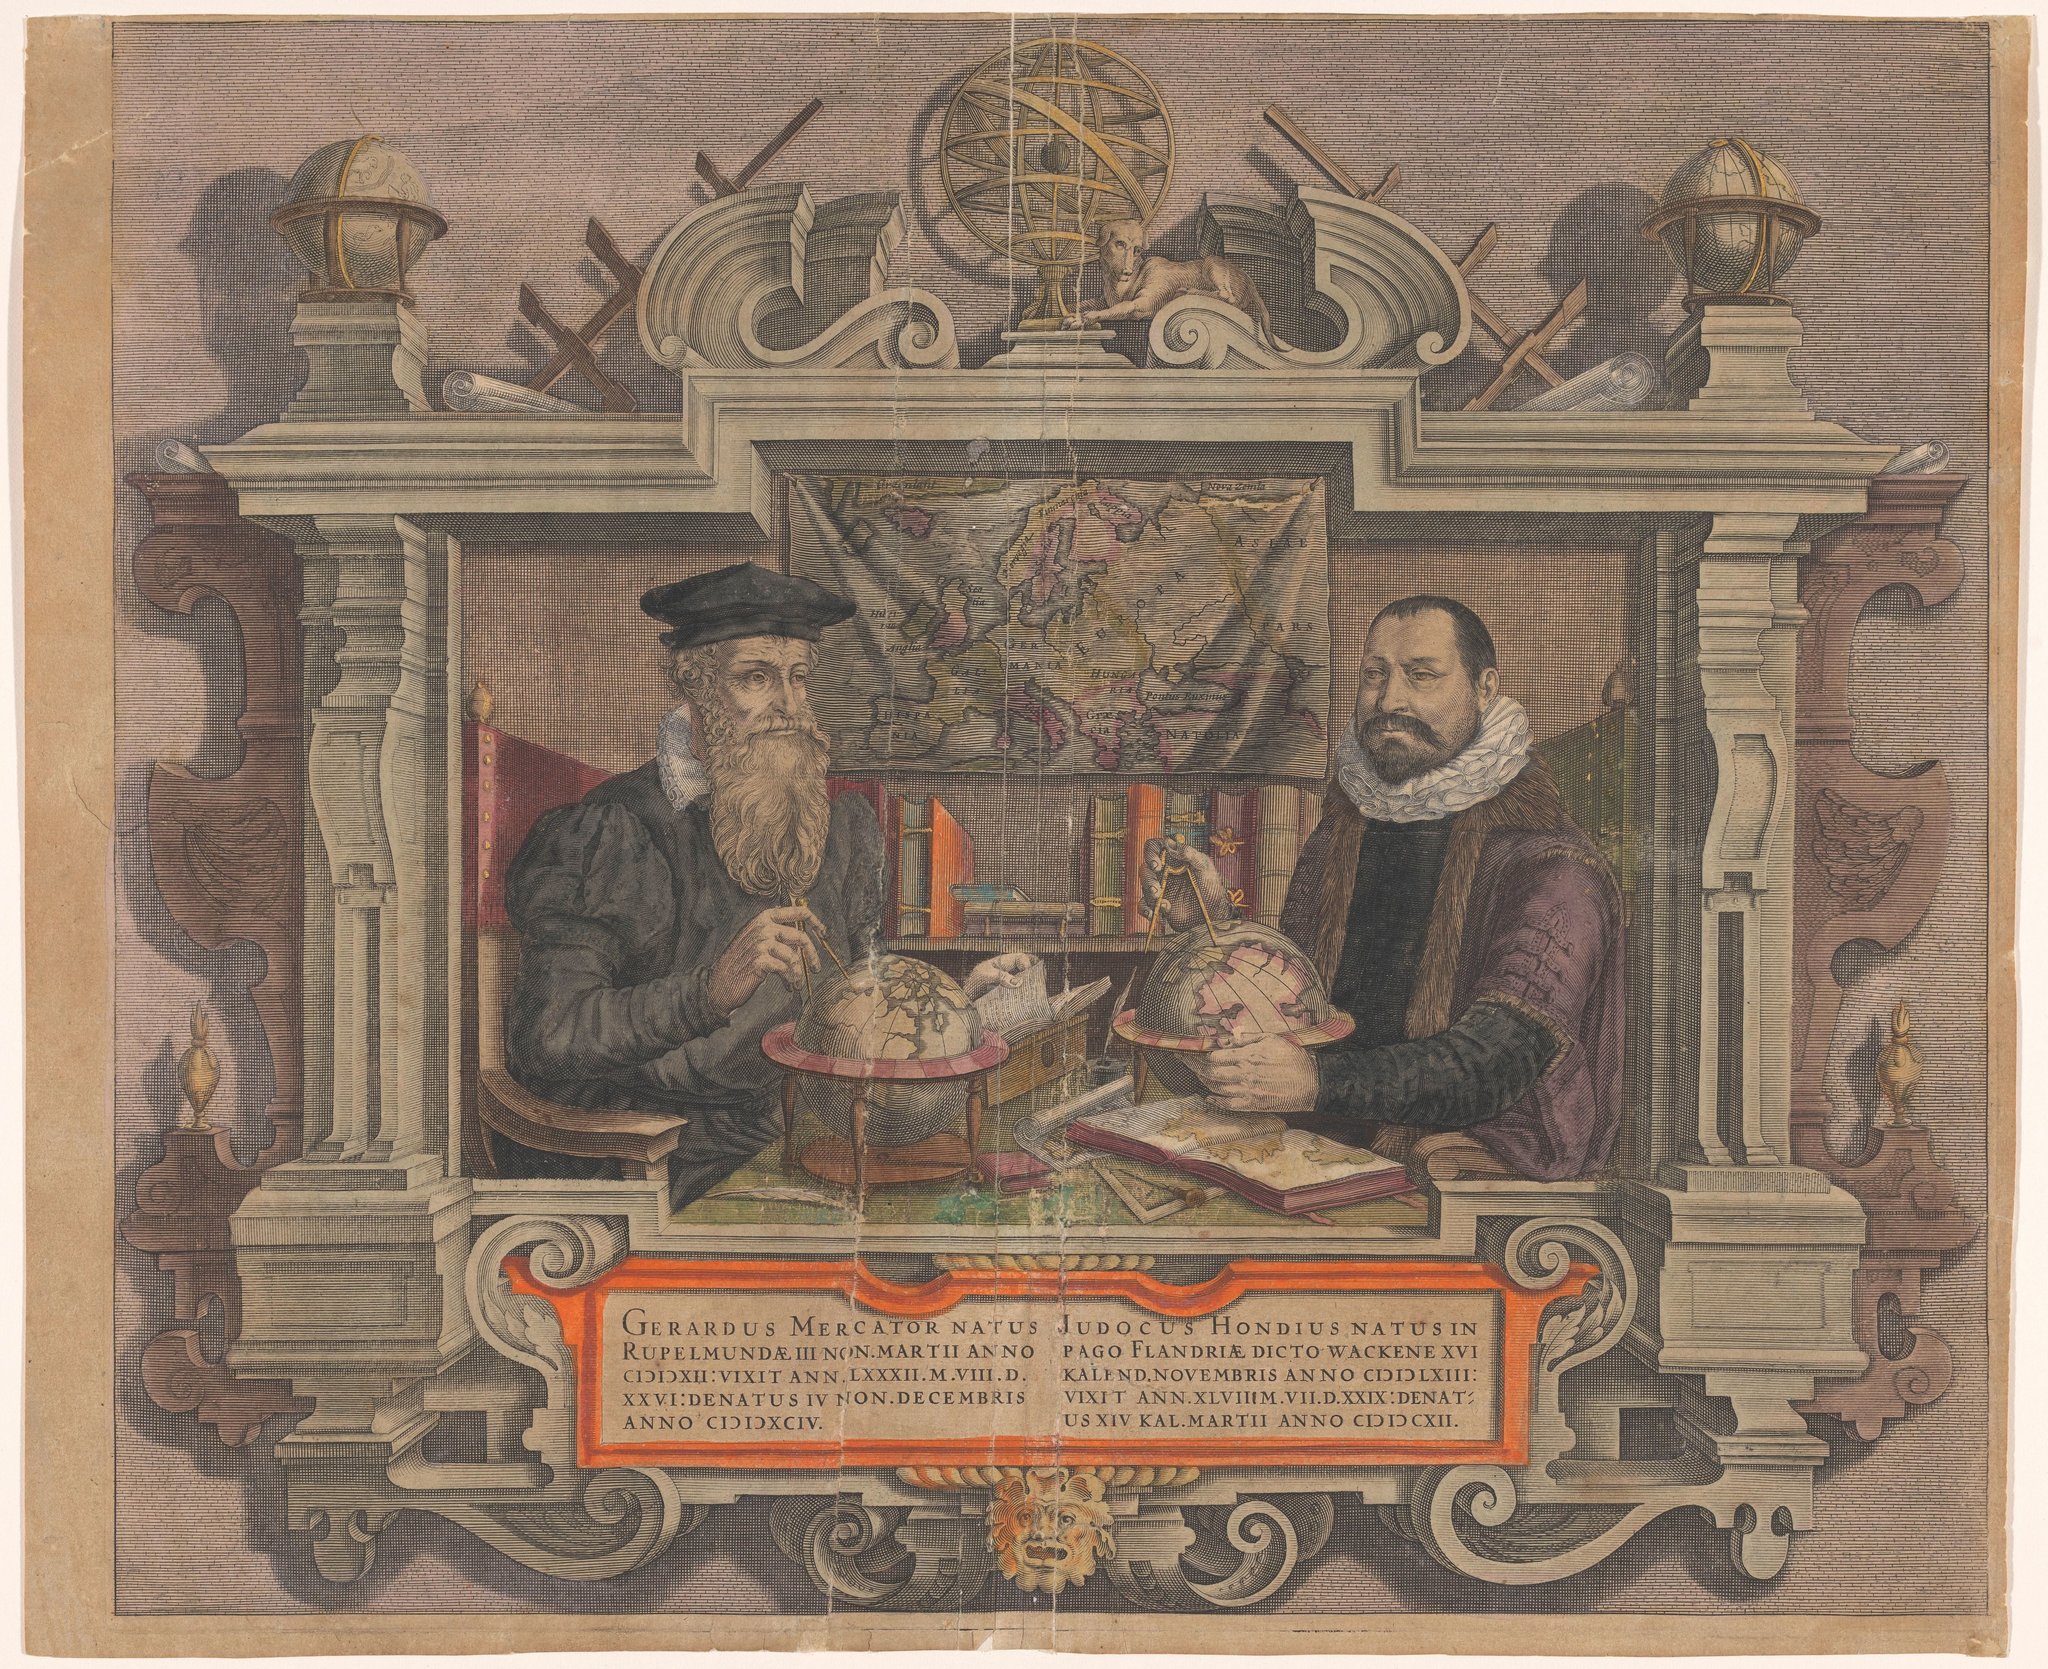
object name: print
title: Portret van Jodocus Hondius en Gerard Mercator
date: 1613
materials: paint, paper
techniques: engraving, hand coloring, letterpress printing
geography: low countries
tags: jodocus hondius, instrument maker, gerardus mercator, maps, atlases, historical persons, science and technology (+ portrait of scholar, scientist), globe, star-globe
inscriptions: collector's mark: Lugt 2228, collector's mark: Lugt 4779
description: De geleerden en cartografen Gerard Mercator (1512-1594) en Jodocus Hondius (1563-1612) zijn samen afgebeeld te midden van hun instrumenten die te maken hebben met hun vak. Beiden hebben landkaarten en hemel- en wereldglobes vervaardigd en astronomische instrumenten geconstrueerd.